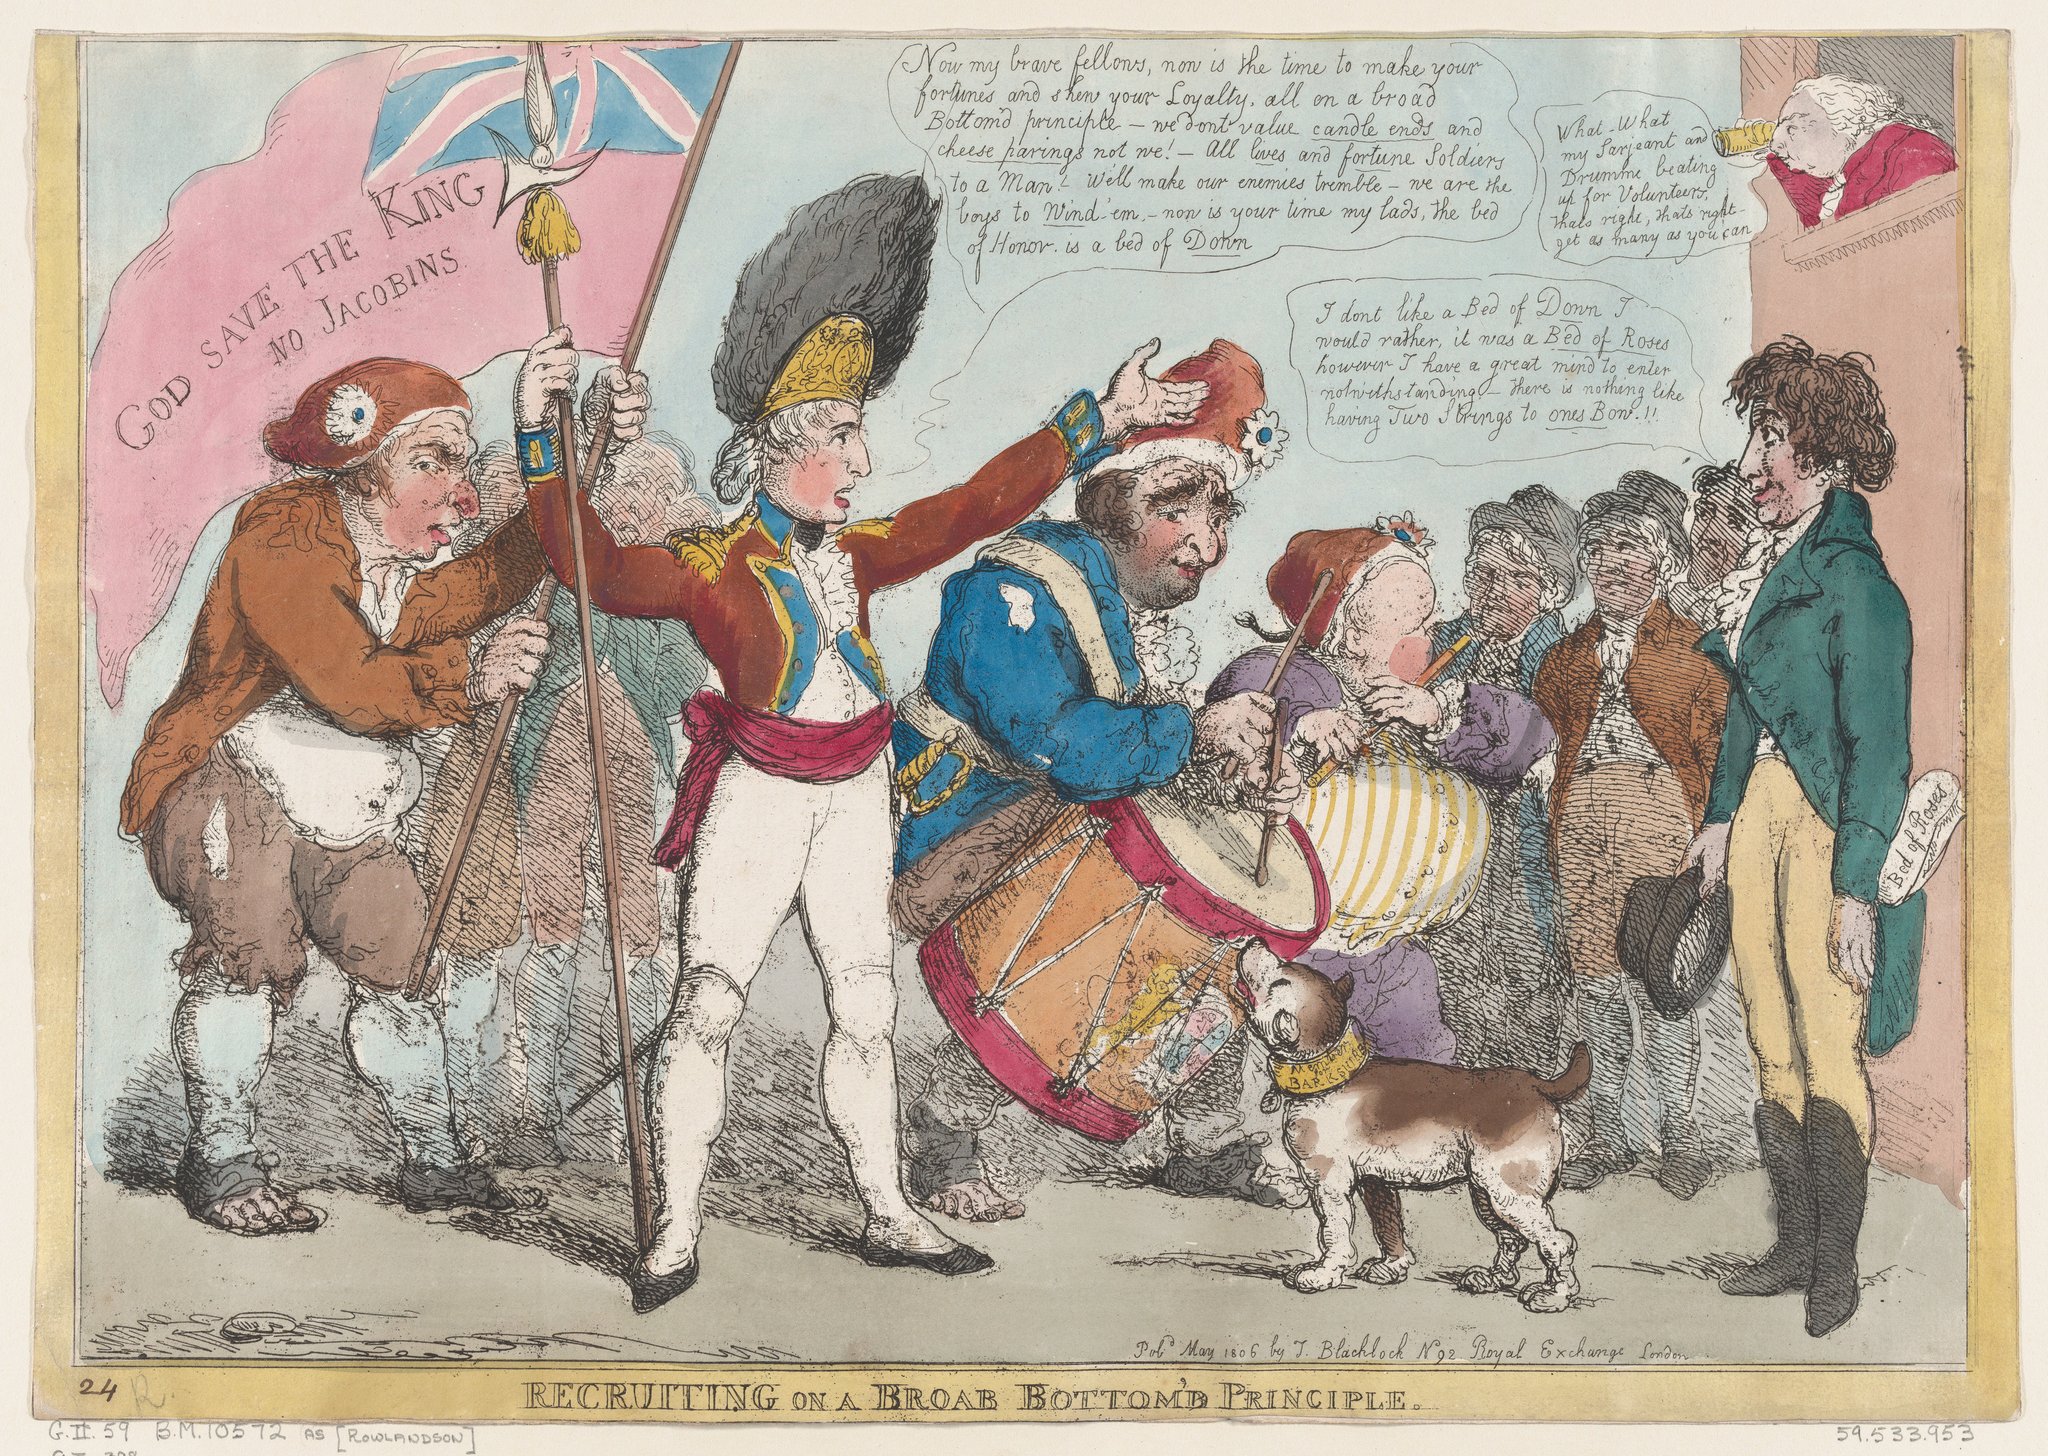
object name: print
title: Recruiting on a Broab [sic] Bottom'd Principle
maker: thomas rowlandson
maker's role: artist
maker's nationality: british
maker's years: 1757-1827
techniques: etching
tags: satire,men,dogs,politics